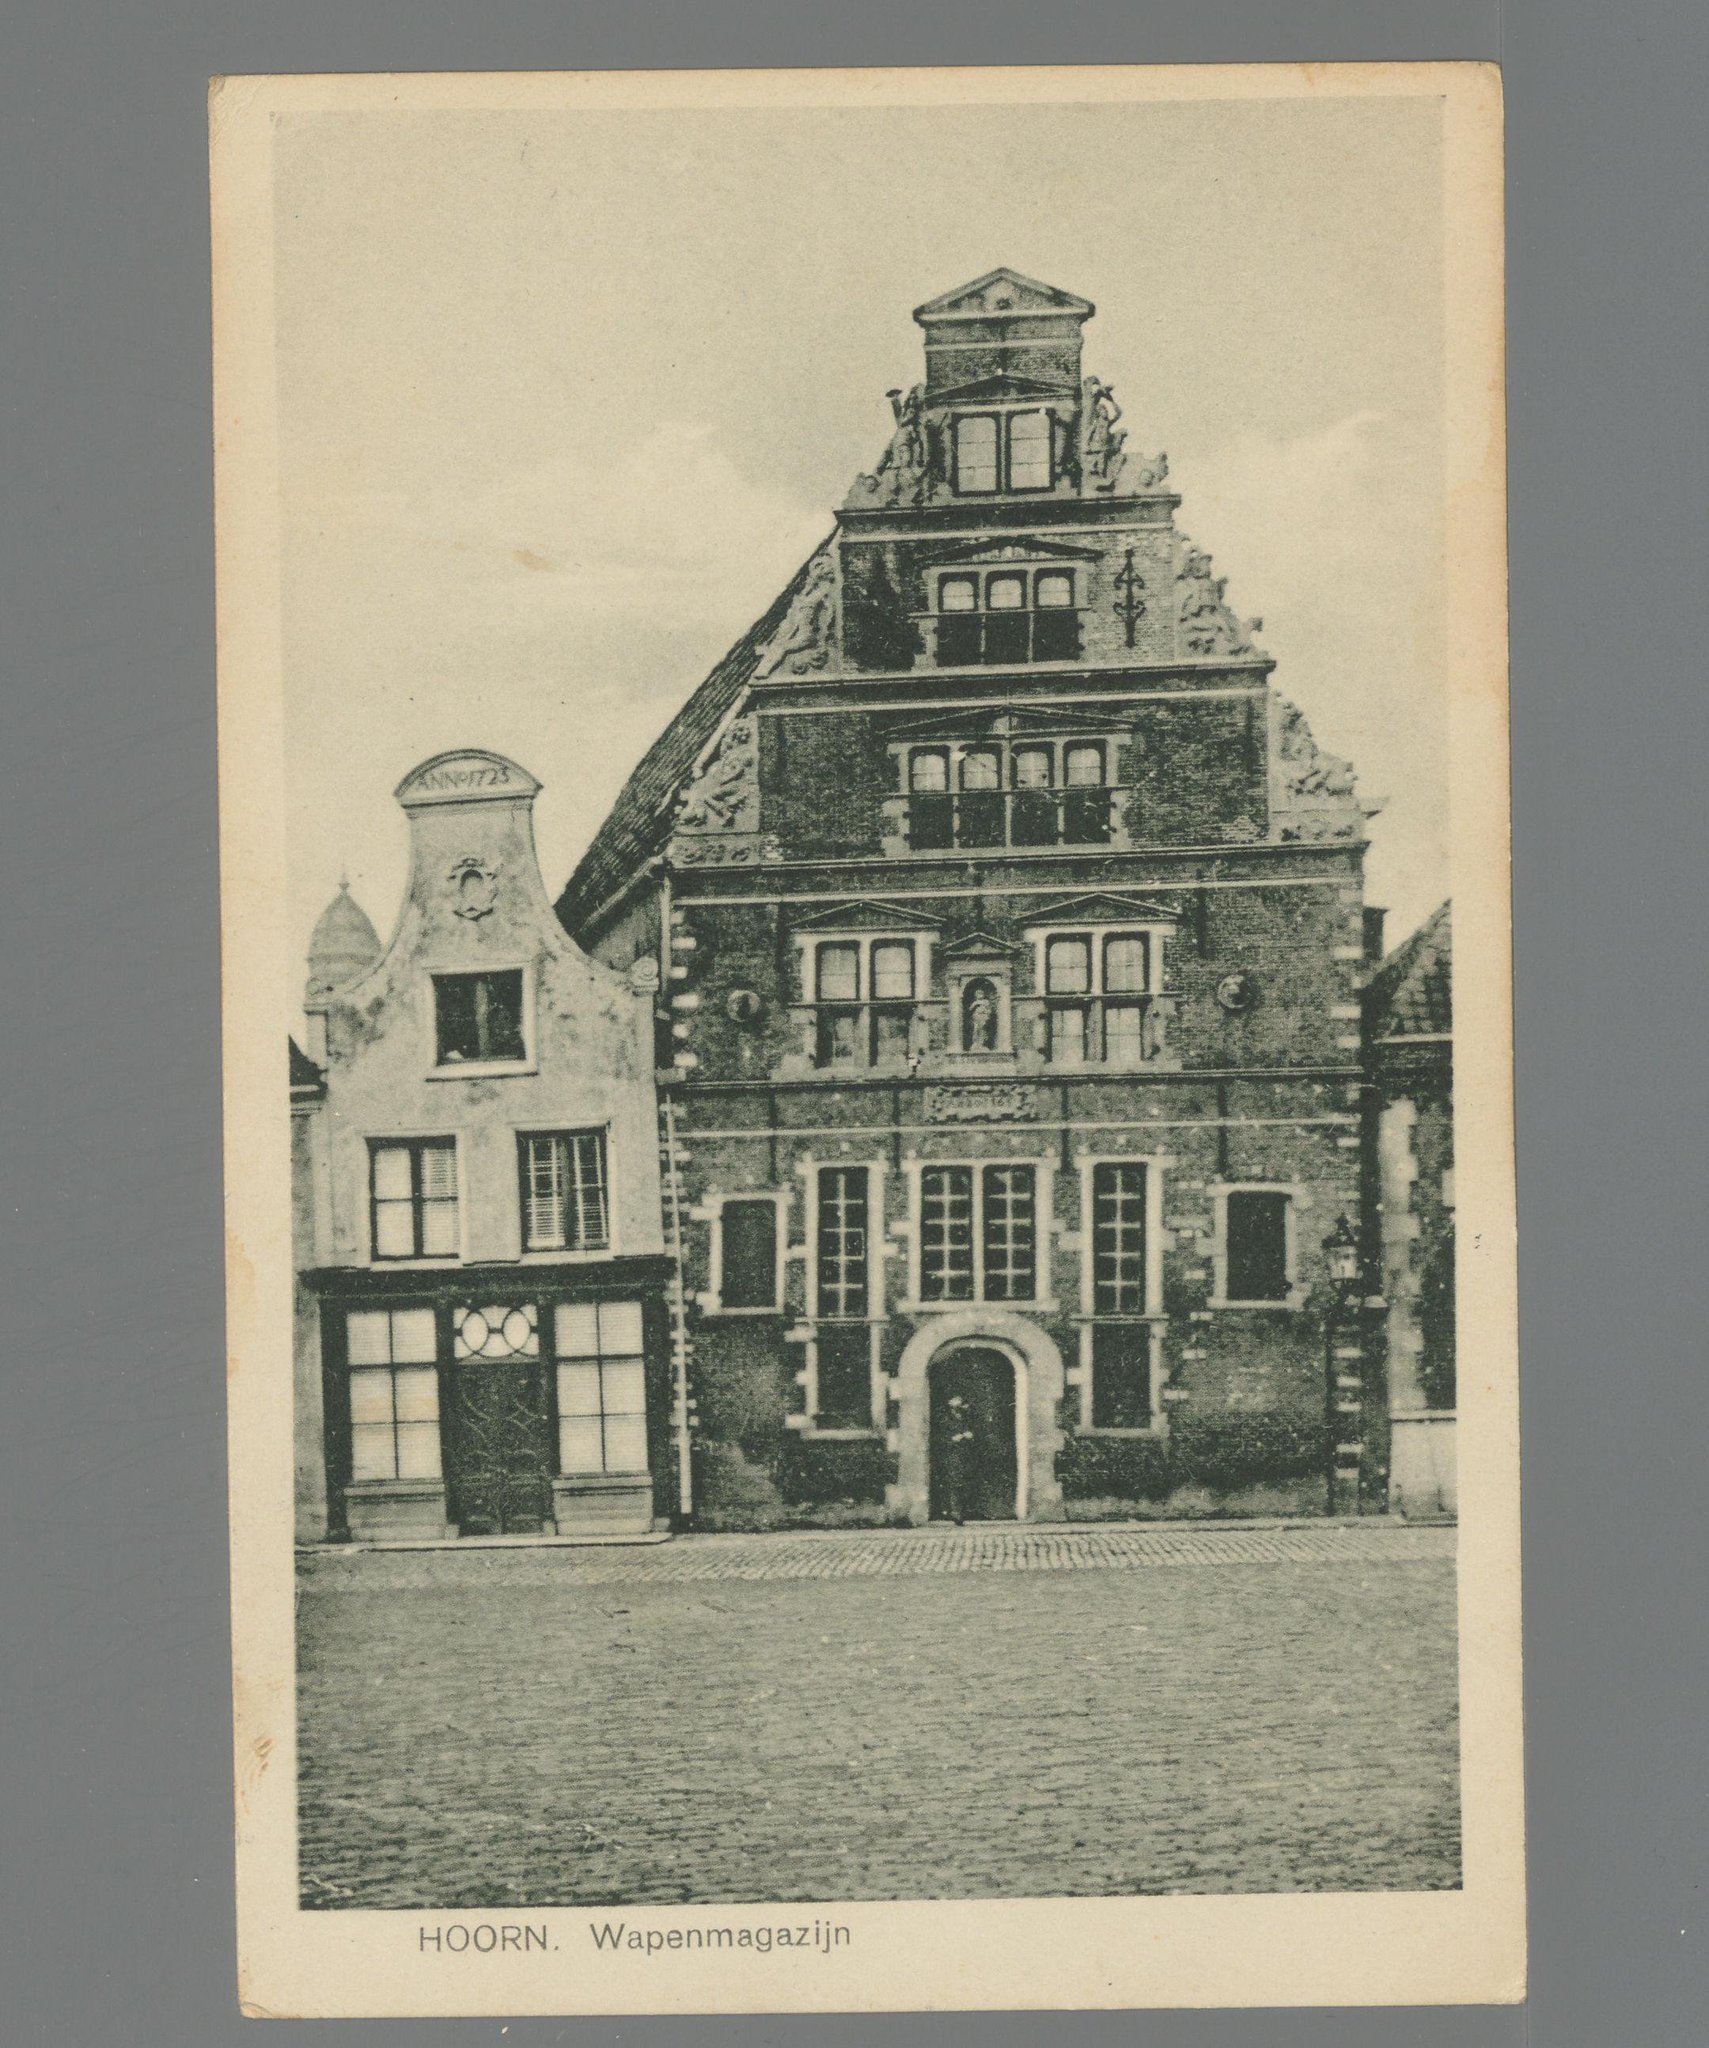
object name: ansichtkaart, prentbriefkaart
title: Hoorn. Wapenmagazijn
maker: Anonymous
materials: cardboard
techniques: photograph, writing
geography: utrecht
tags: city-view, and landscape with man-made constructions, ammunition store, arsenal, hoorn (north holland)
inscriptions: postage stamp